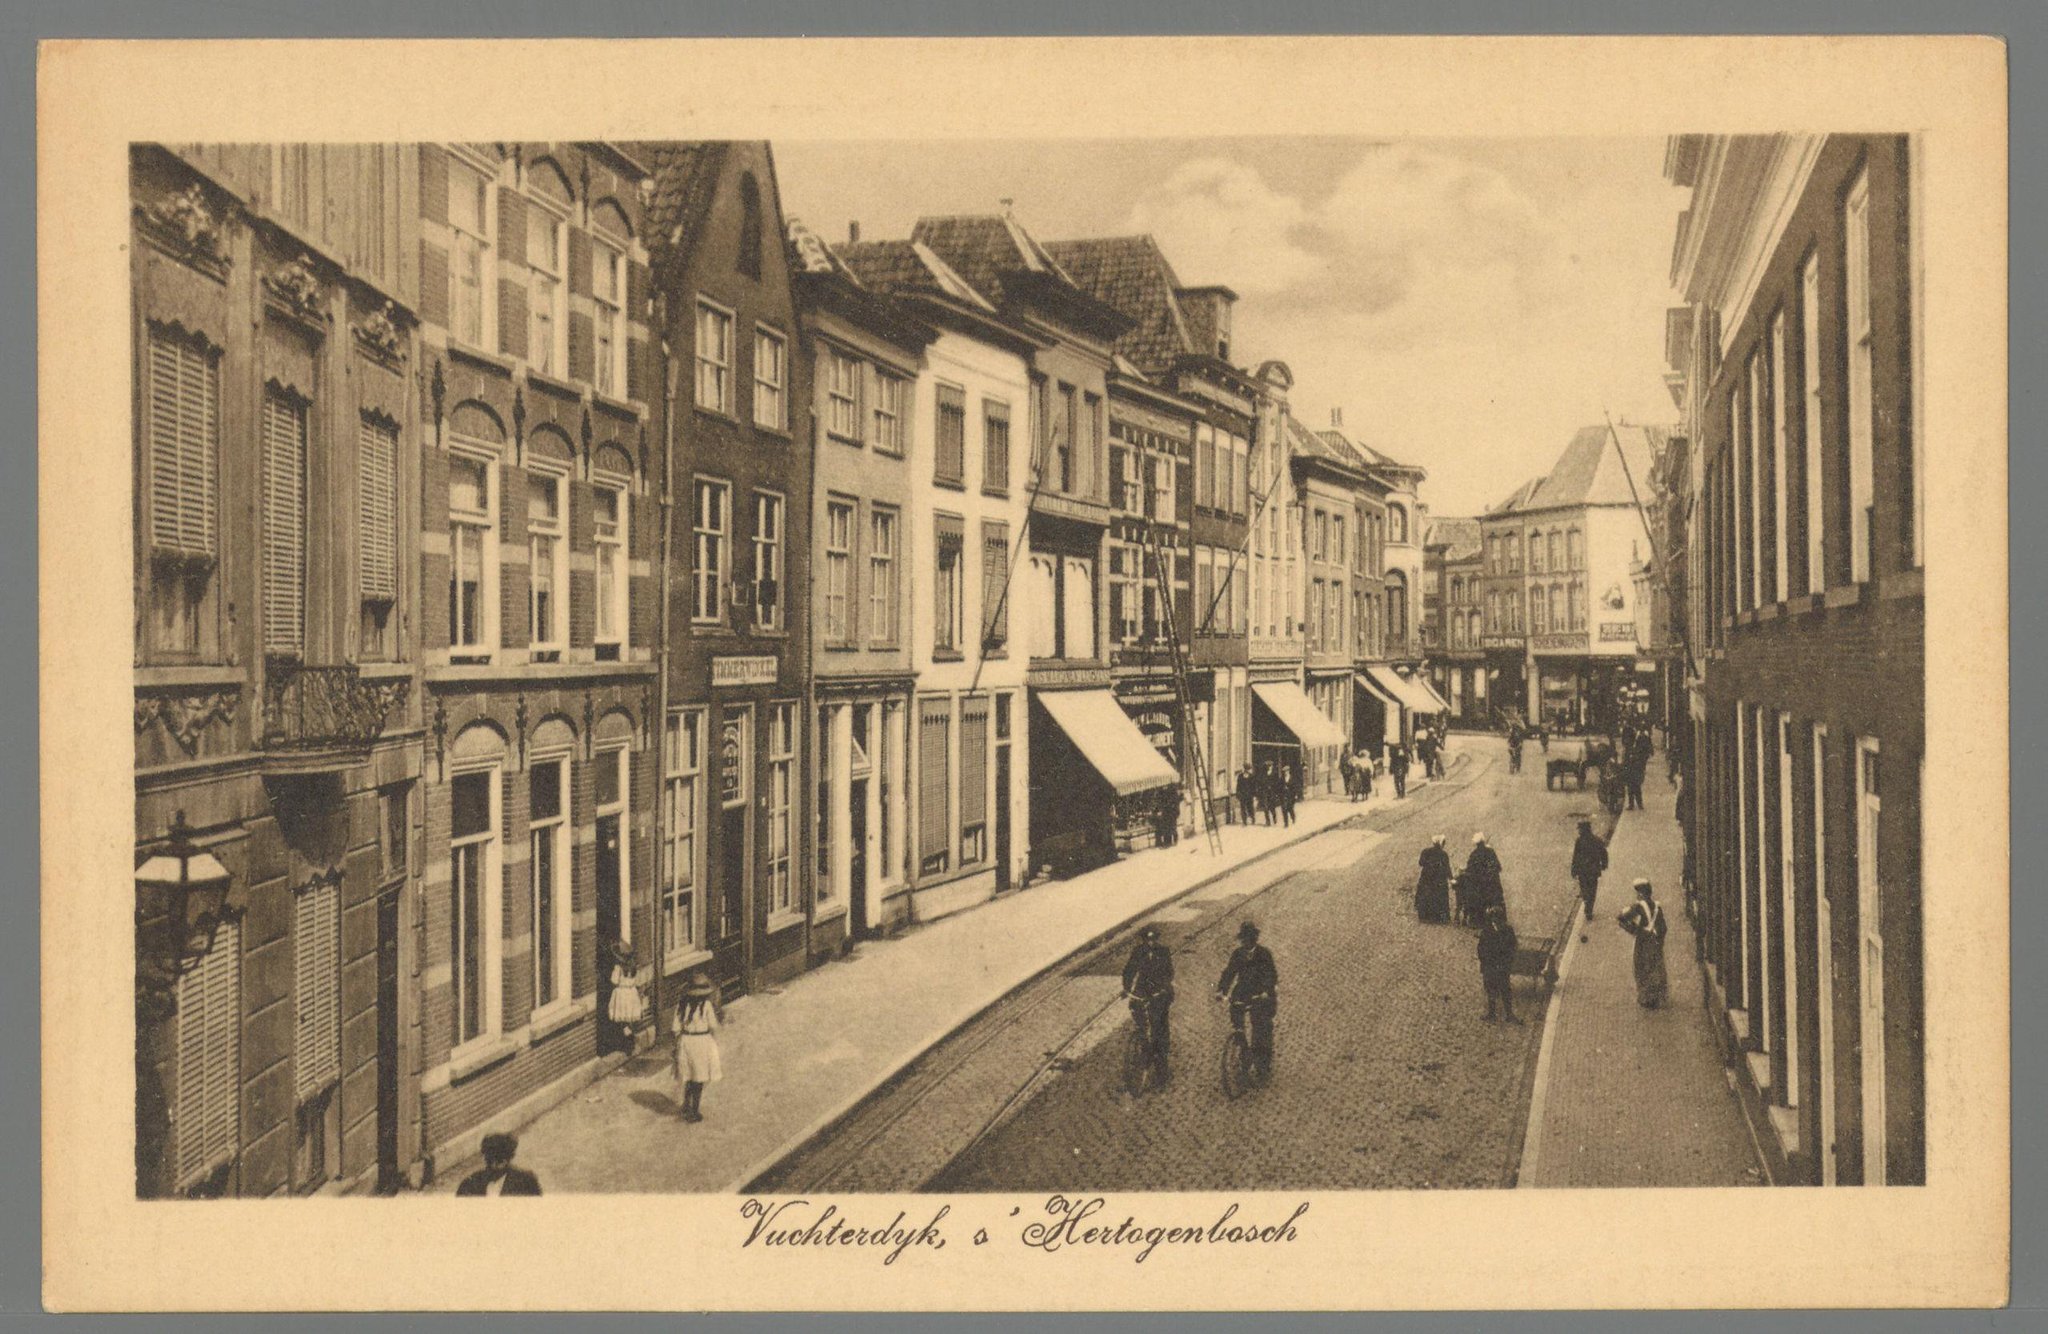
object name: ansichtkaart, prentbriefkaart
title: Vuchterdijk, s'Hertogenbosch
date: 1913-1930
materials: cardboard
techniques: photograph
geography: den bosch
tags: street, den bosch